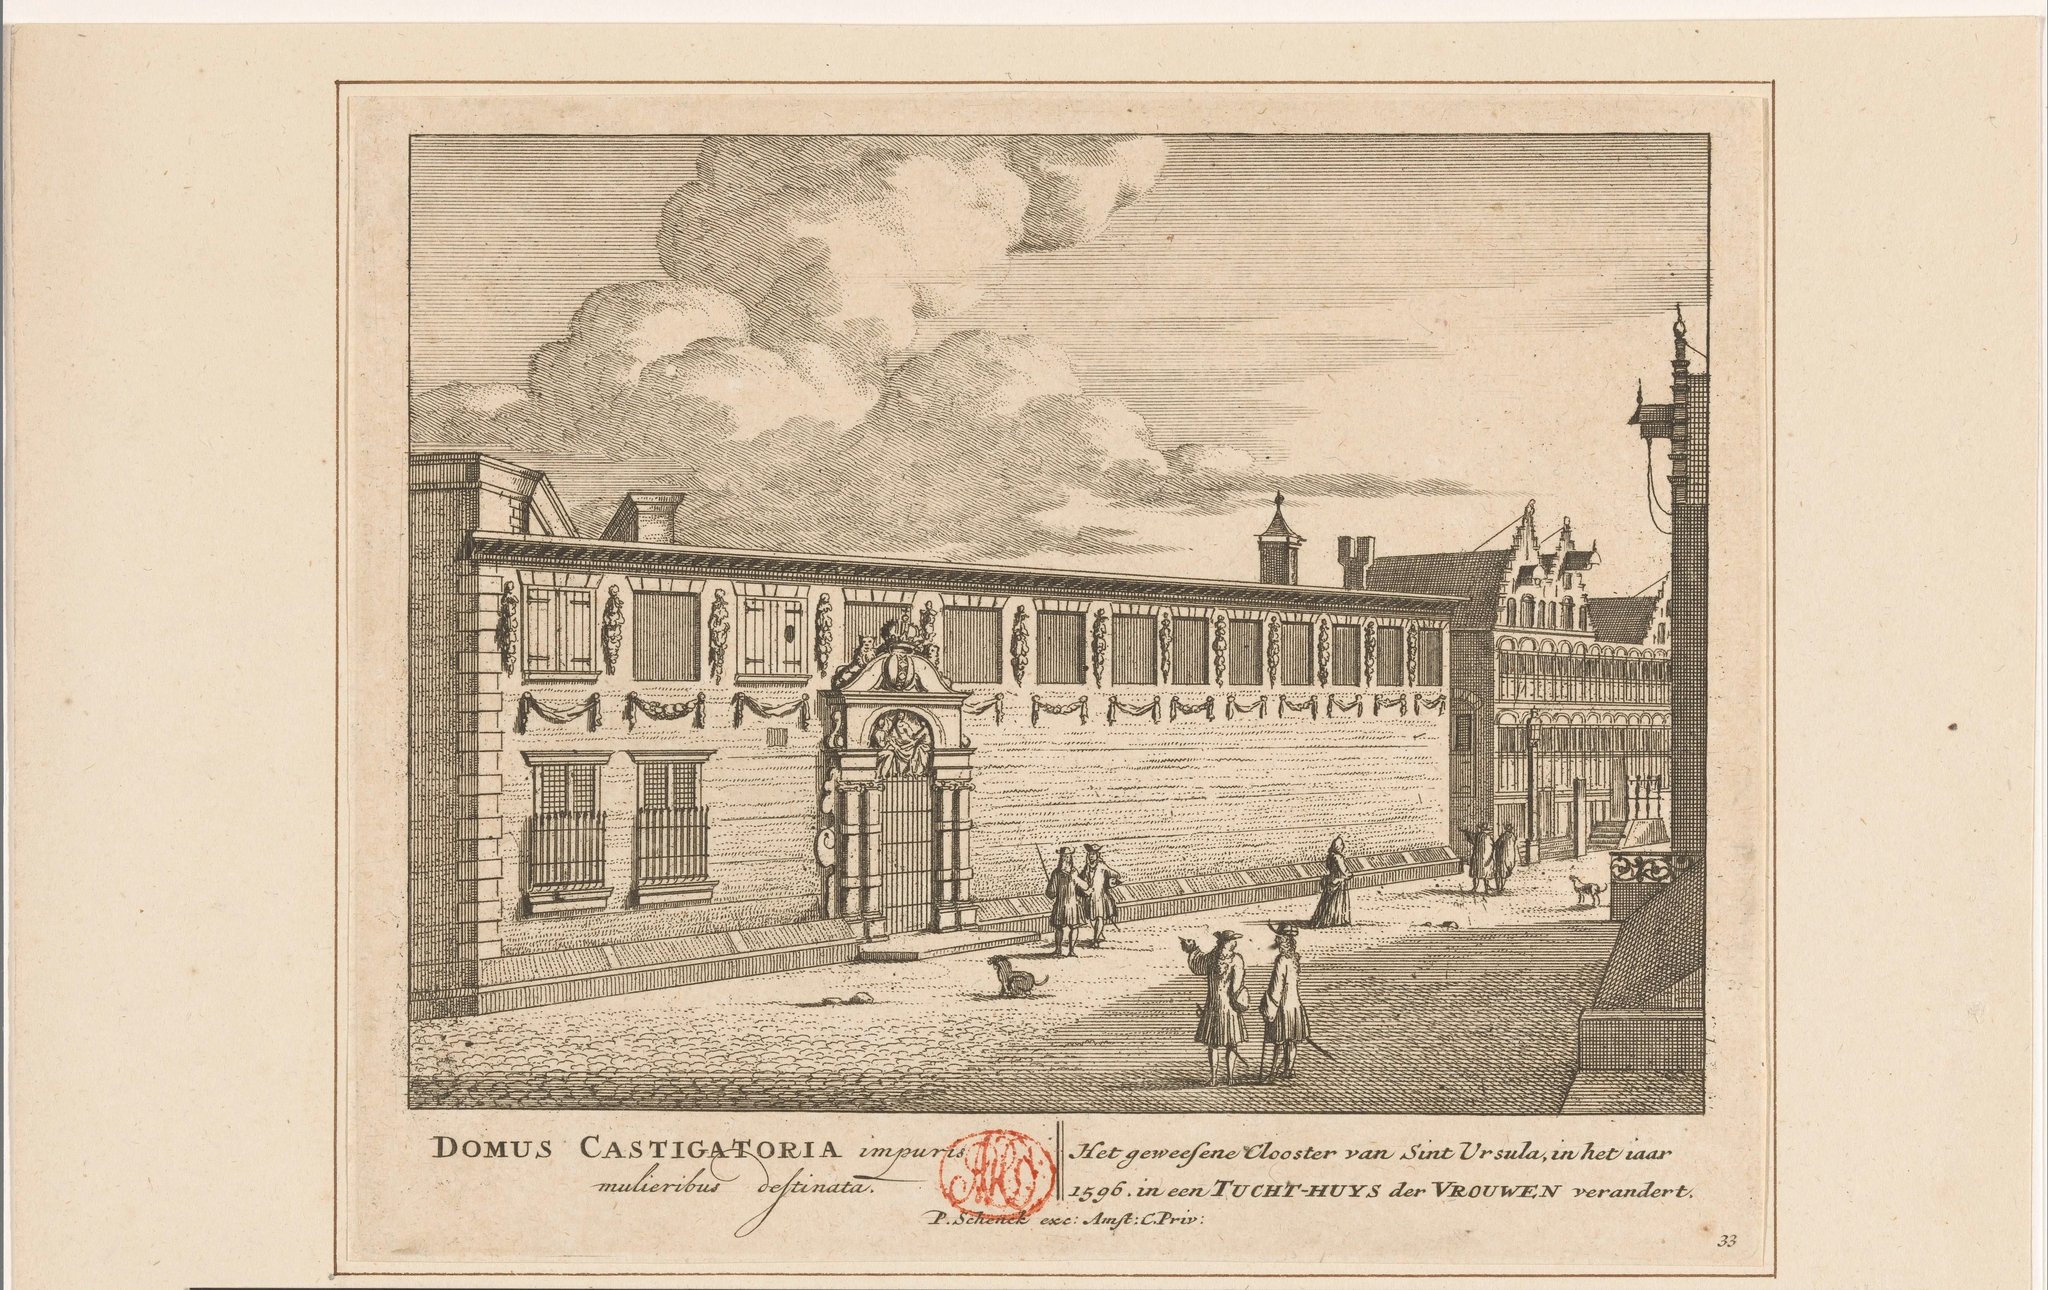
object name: print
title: 100 Afbeeldinge der voornaamste gebouwen van Amsterdam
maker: Anonymous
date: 1710-1711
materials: paper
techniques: engraving, etching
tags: prison, jail, gate, entrance, workhouse, penal camp, penitentiary, chain gang, street (+ city(-scape) with figures, staffage)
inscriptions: collector's mark: Lugt 195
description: Huidige staat van prent ook gebruikt in: 100 Afbeeldinge der voornaamste gebouwen van Amsterdam. Amsterdam, Pieter Schenk (I), s.a. [1710-1711]. En in: 100 Afbeeldinge der voornaamste gebouwen van Amsterdam. Amsterdam, Barent Greve, s.a. [1757-1766].* *In de tweede uitgave, uitgegeven door Barent Greve, is alleen de titelprent aangepast. De overige prenten zijn onveranderd gebleven.